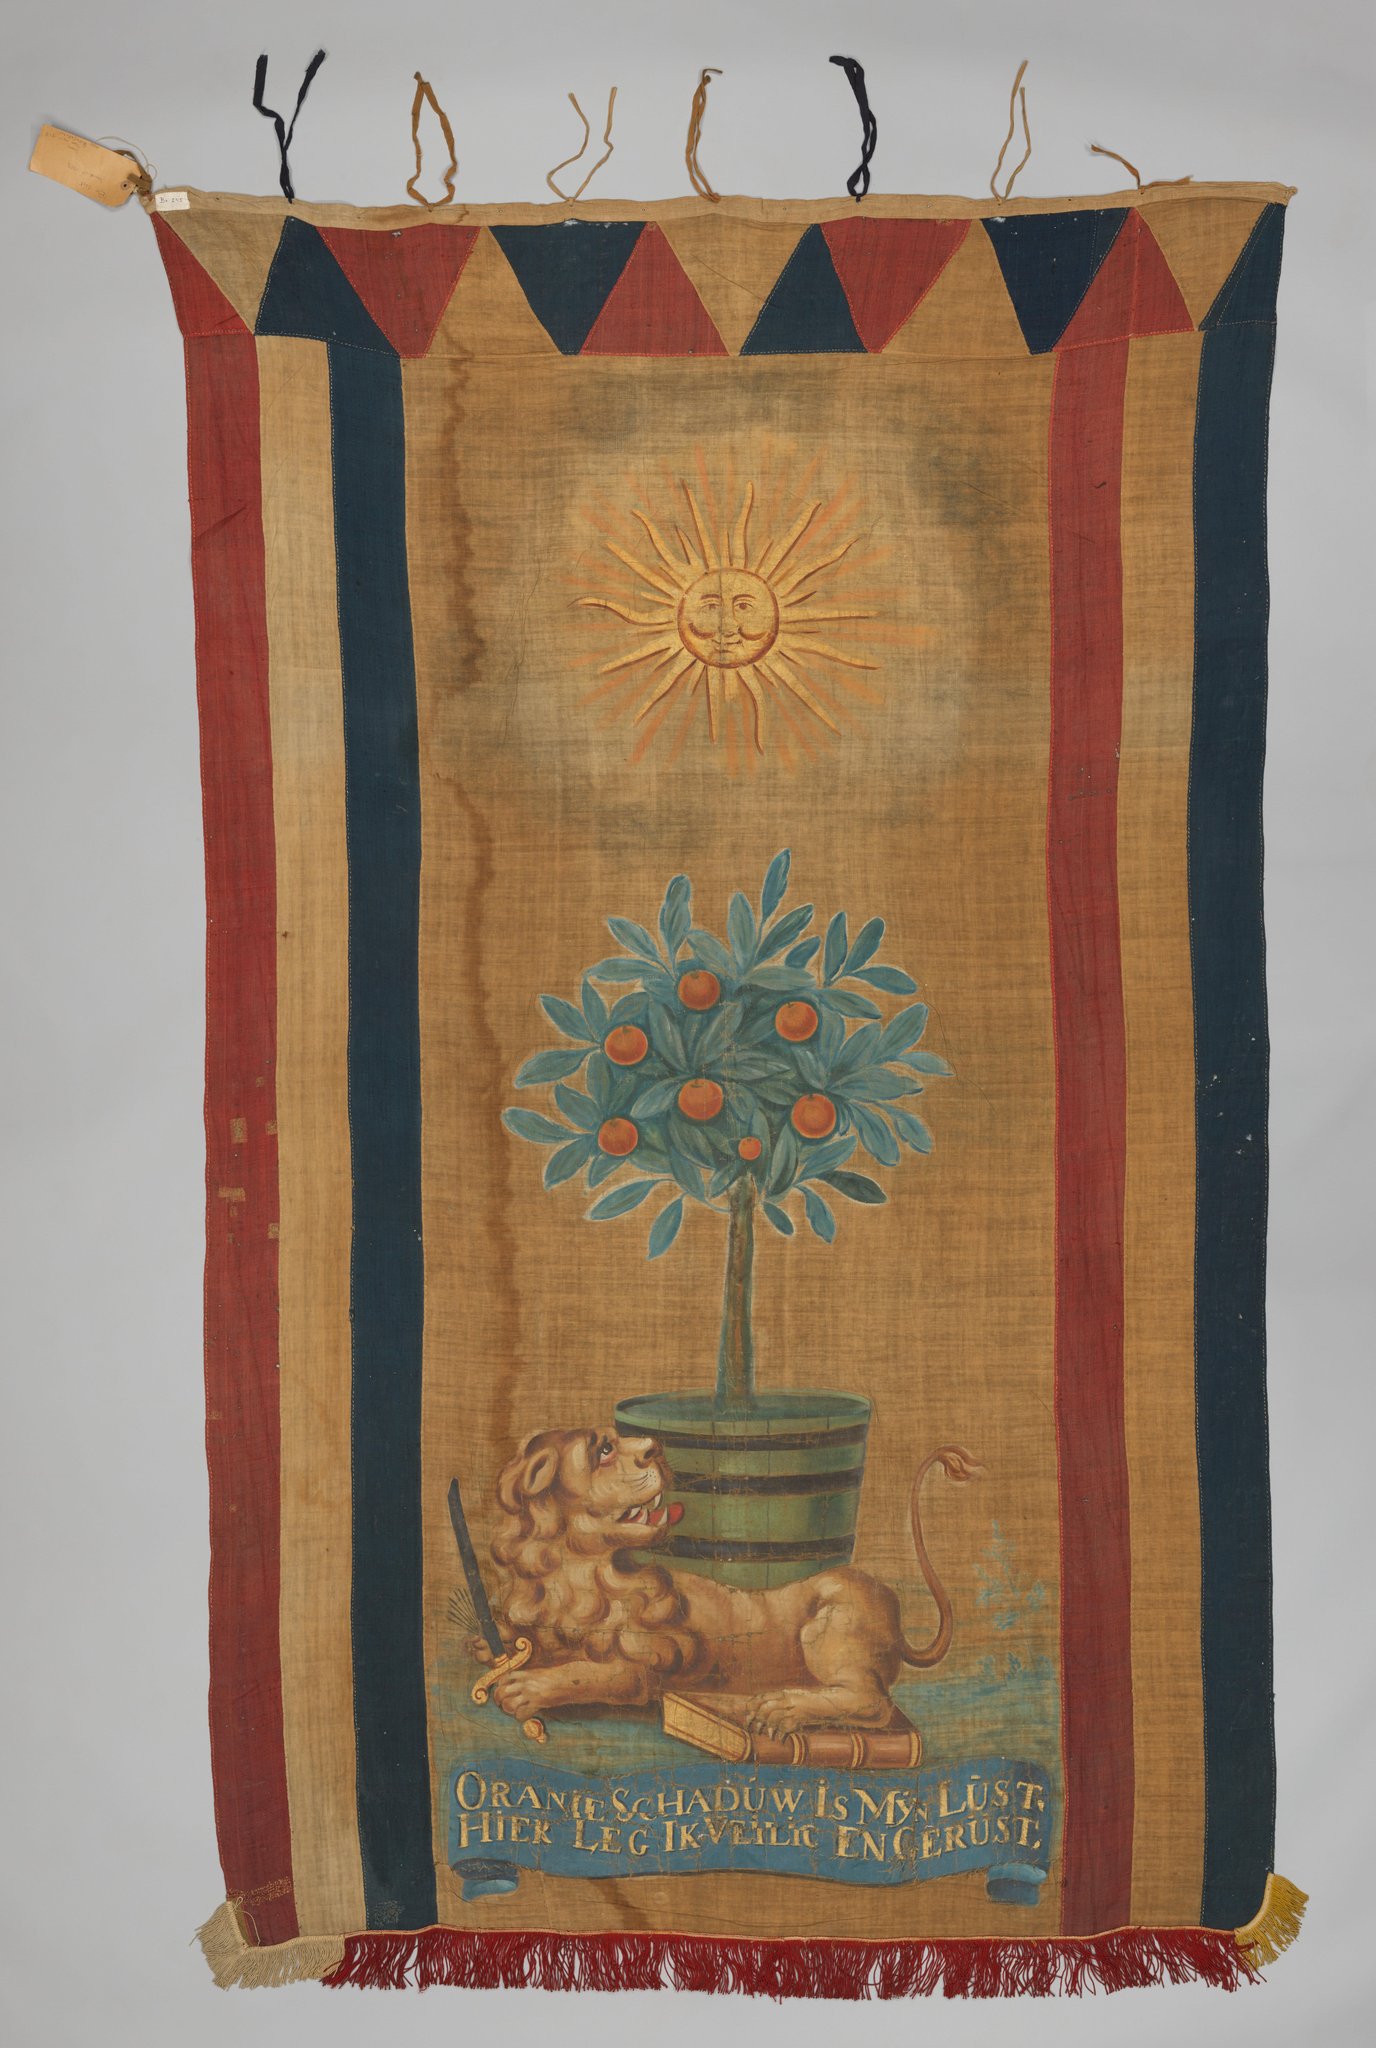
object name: flag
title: Nederlandse vlag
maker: Anonymous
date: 1787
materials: linen, paint, wool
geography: netherlands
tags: netherlands